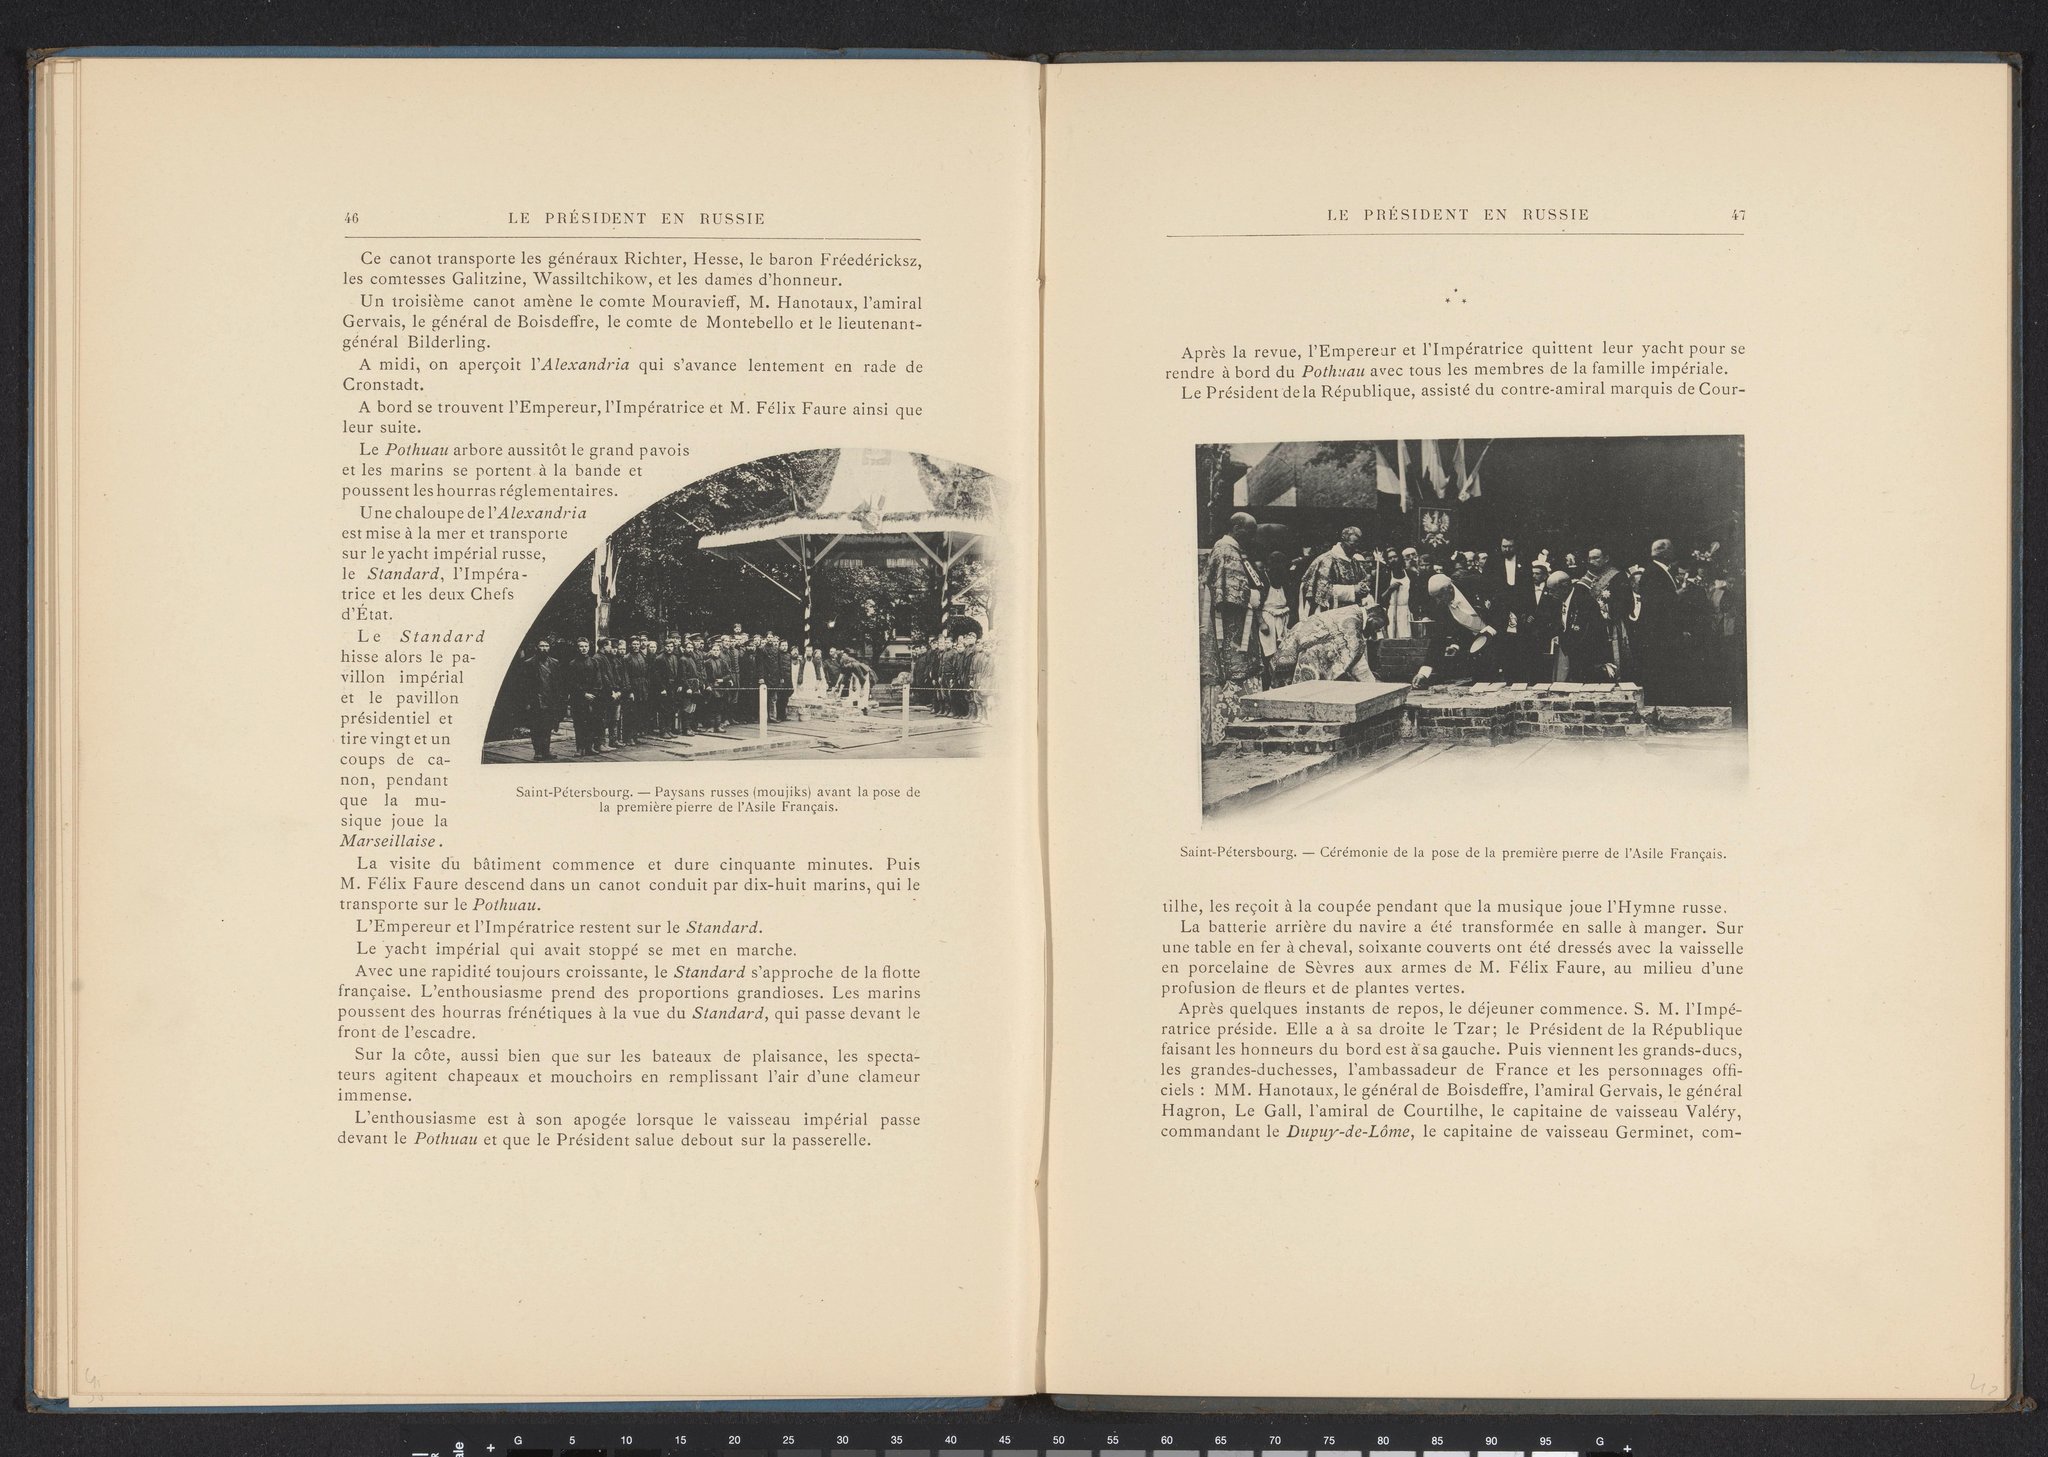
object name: page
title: Russische boeren bij het leggen van de eerste steen van een Frans opvangcentrum te Sint-Petersburg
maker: Anonymous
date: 1897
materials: paper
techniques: photograph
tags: ceremonial laying of the foundations, laying the first stone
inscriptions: inscription: ‘Saint-Pétersbourg.- (...) l'Asile Français.’